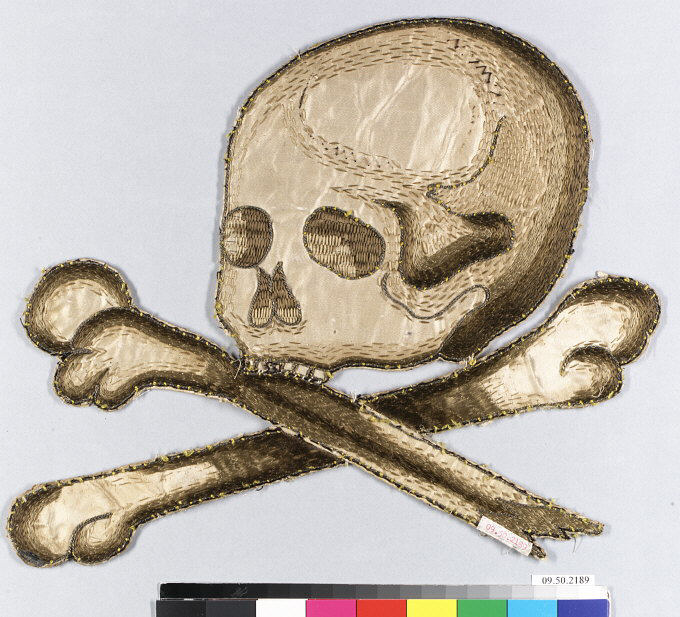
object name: appliqué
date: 1801-1900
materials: metal thread, silk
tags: skulls